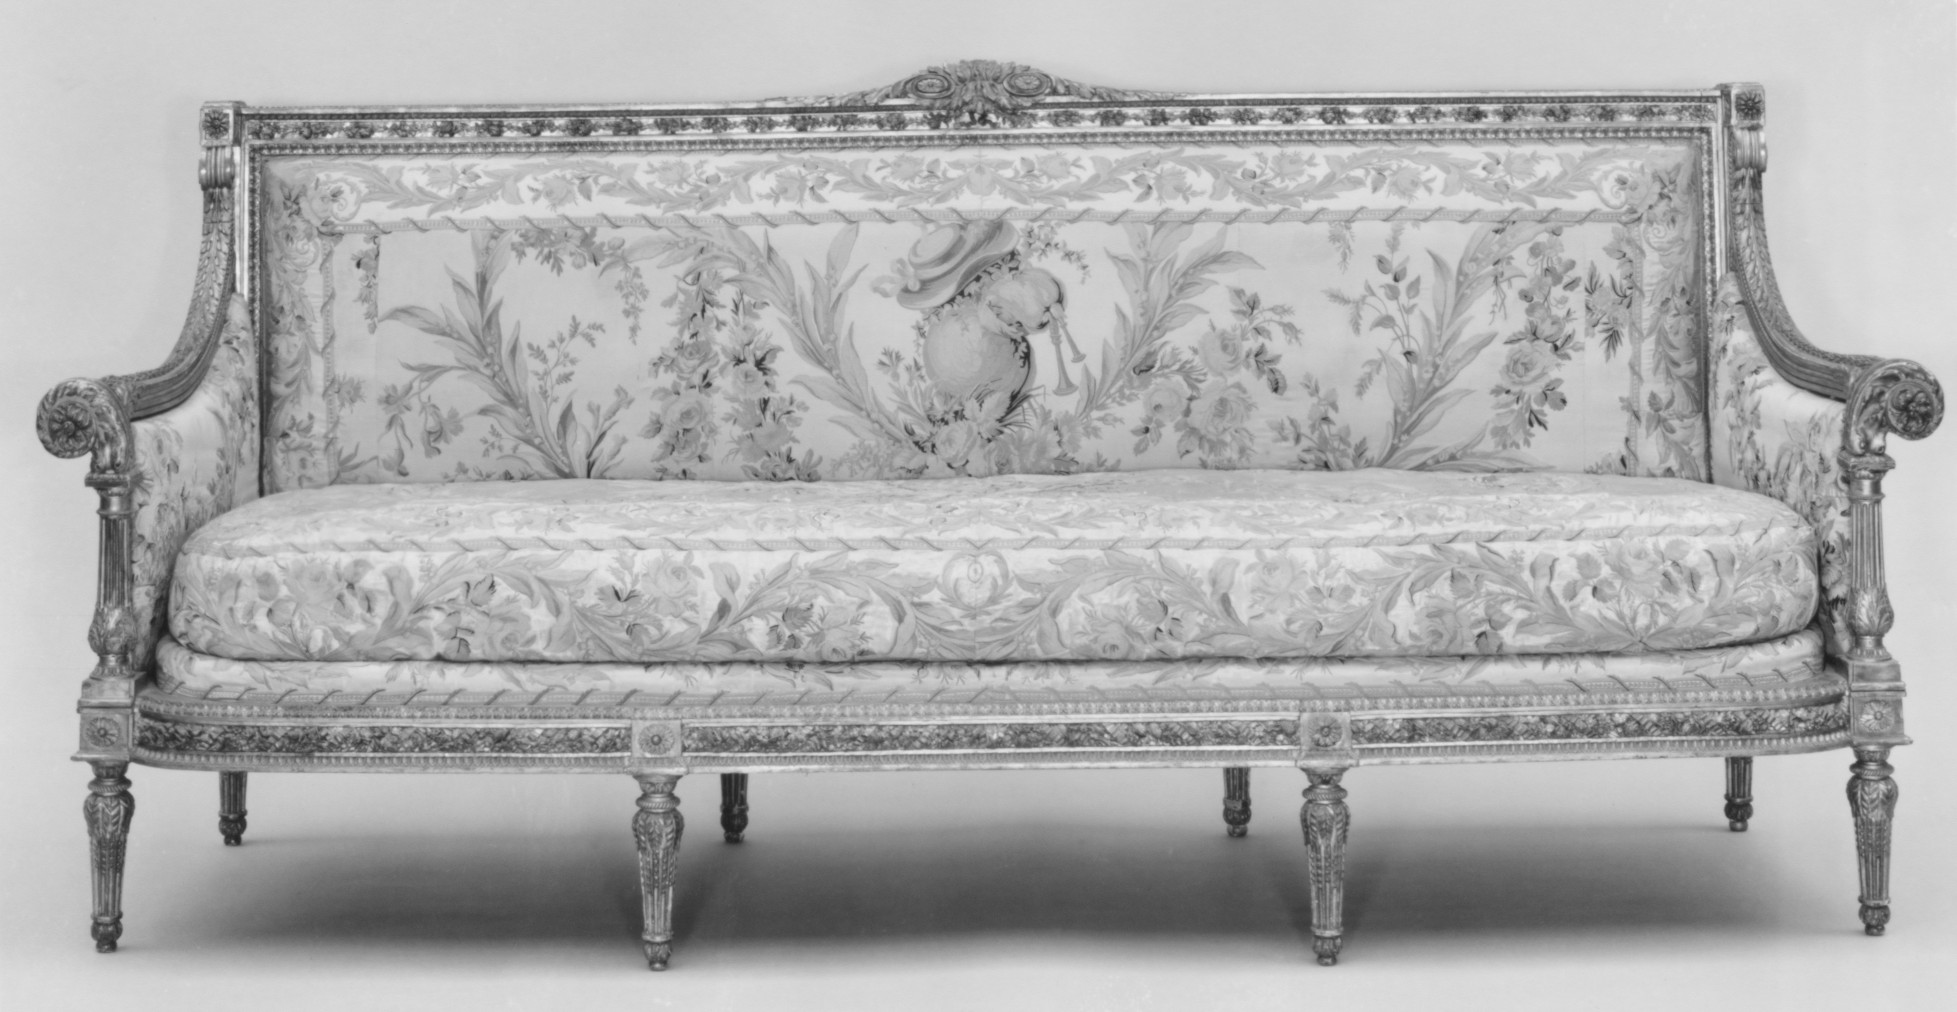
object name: sofa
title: Sofa (part of a set)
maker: philippe de lasalle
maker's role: designer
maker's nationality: french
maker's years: 1723-1804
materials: textile, wood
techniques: carving, embroidery, gilding